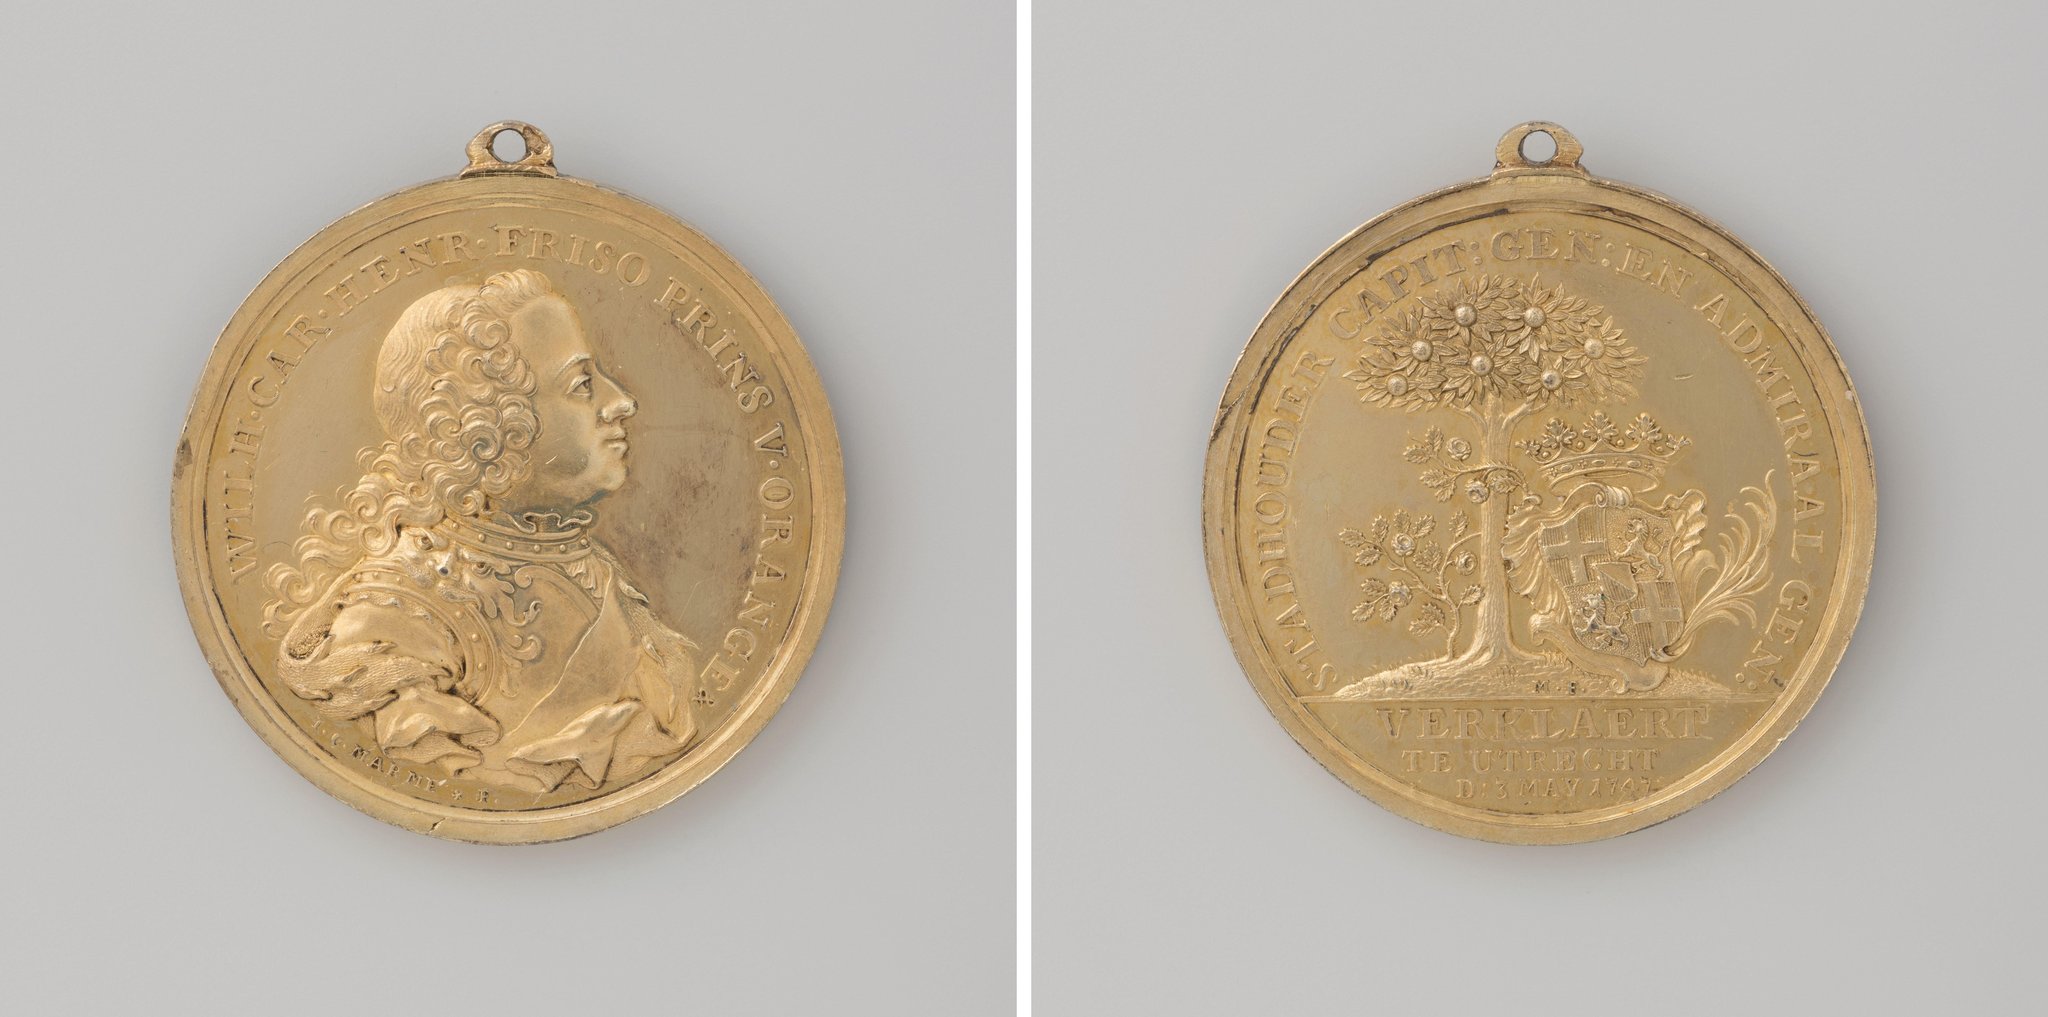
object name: history medal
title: Verheffing van de prins van Oranje tot stadhouder door de Staten van Utrecht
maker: johann conrad marmé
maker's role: die cutter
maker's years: 1710-1772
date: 1747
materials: silver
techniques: gilding, striking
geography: germany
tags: the hague, willem iv (prins van oranje-nassau), utrecht